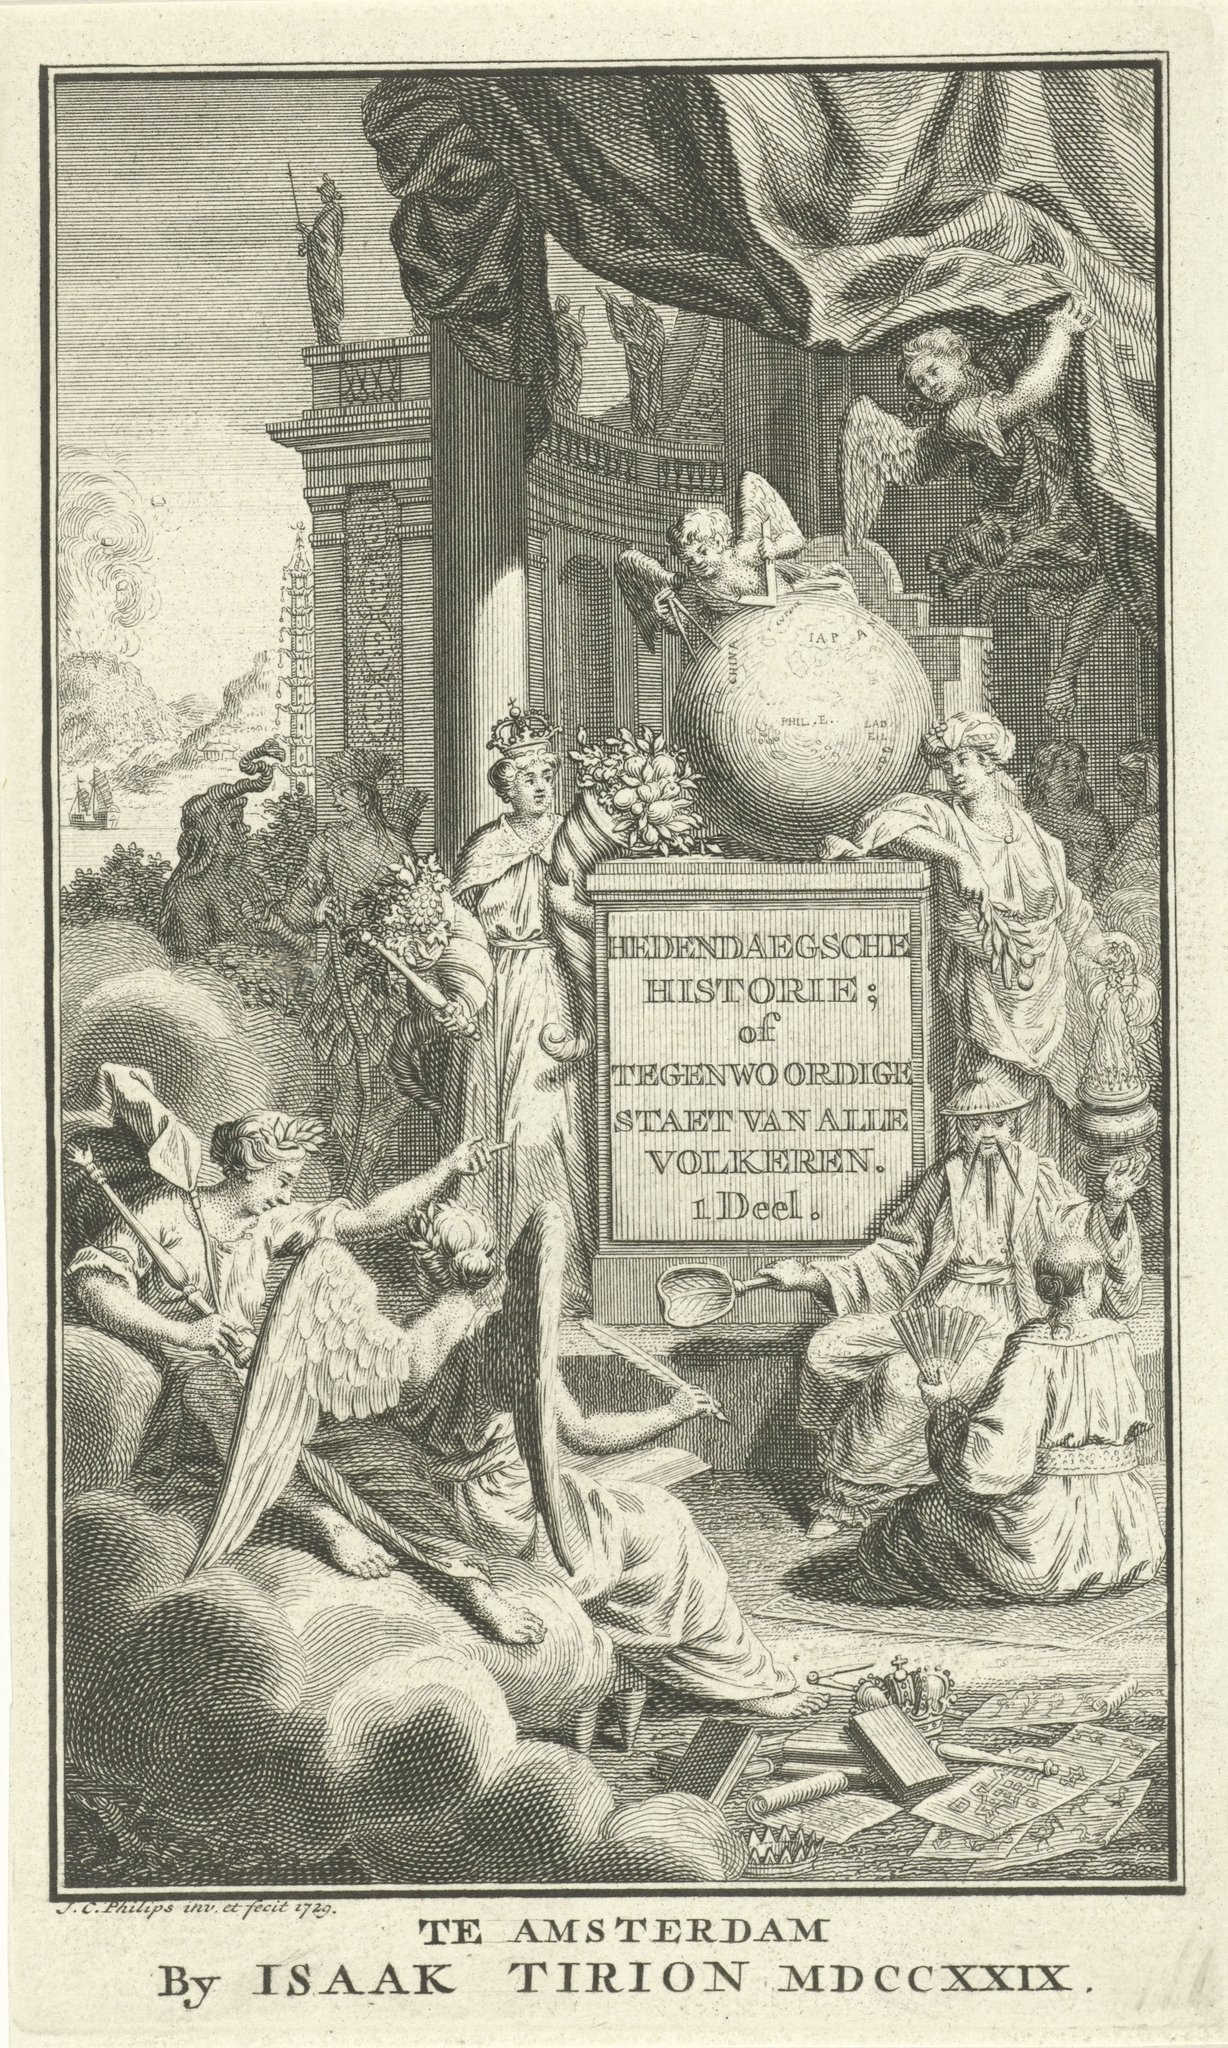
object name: titelblad, titelpagina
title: Titelpagina voor: T. Salmon, Hedendaagsche historie, of Tegenwoordige staat van alle volkeren, 1729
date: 1729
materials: paper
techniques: engraving, etching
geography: amsterdam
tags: hand, arm of justice (symbol of sovereignty), 'historia'; 'historia' (ripa), globe, human races; peoples; nationalities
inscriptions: collector's mark: Lugt 2228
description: Landschap met een architecturale nis waarin afgevaardigden van de volken van verschillende continenten zich hebben verzameld. Op de voorgrond Geschiedenis die in haar boek schrijft. Zij wordt vergezeld door een vrouw, in de hand de Hand van Justitie, die wijst naar het monument waarop de titel in het Nederlands. Op het monument een putto op een globe.